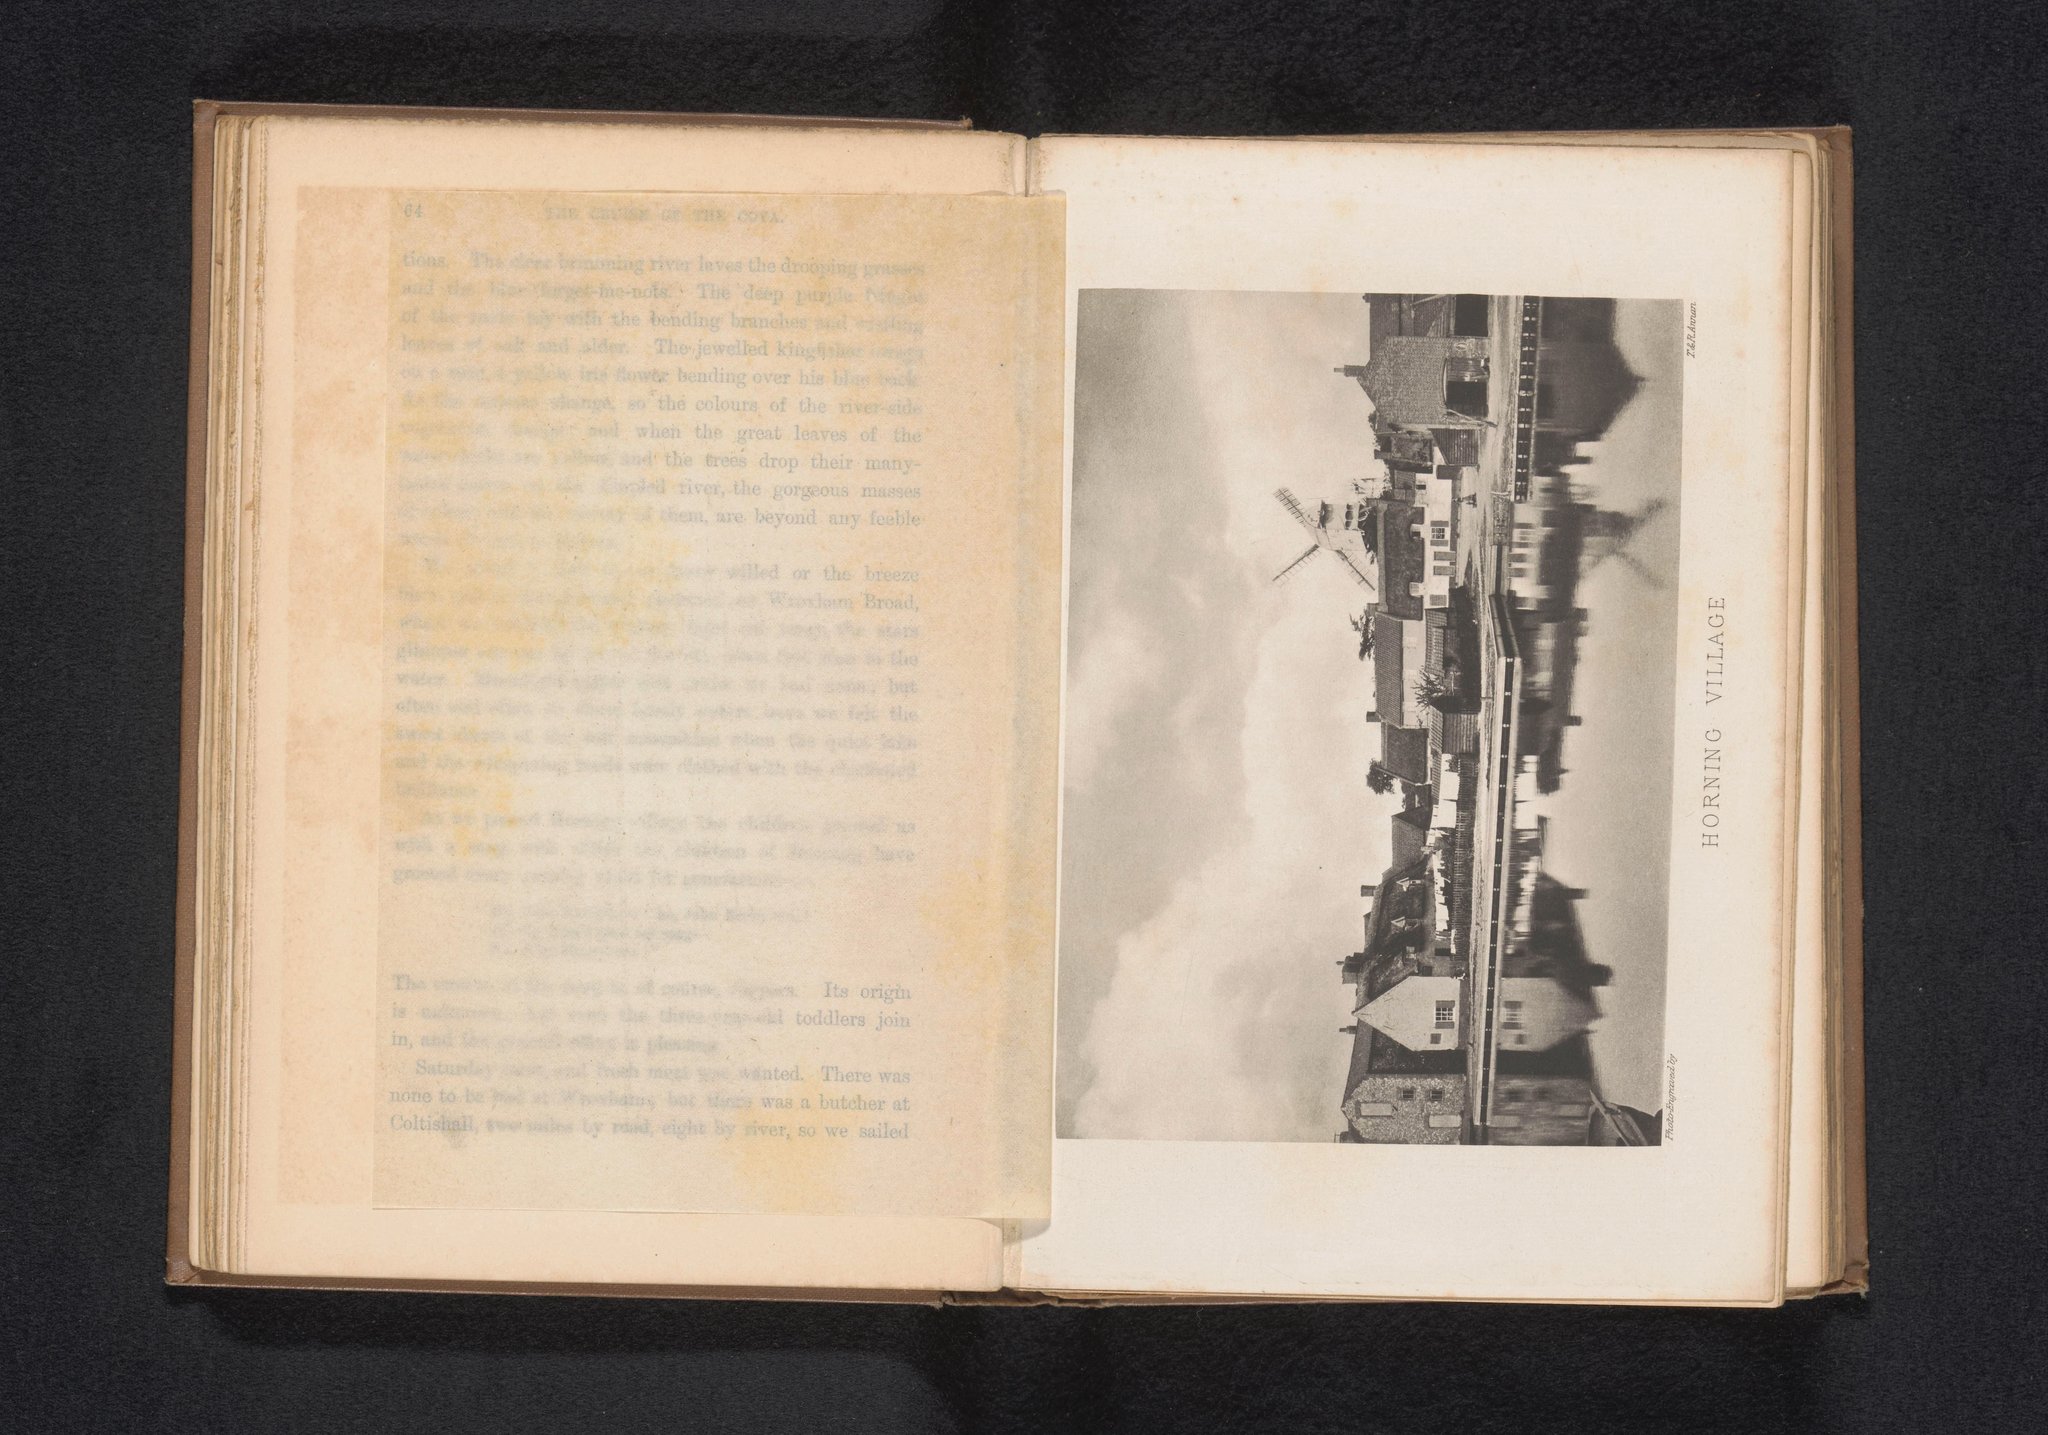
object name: page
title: Horning Village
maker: george christopher davies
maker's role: fotograaf, geoloog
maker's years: 1849-1922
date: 1878-1883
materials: paper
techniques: photoaquatint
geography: horning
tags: city-view in general; 'veduta'